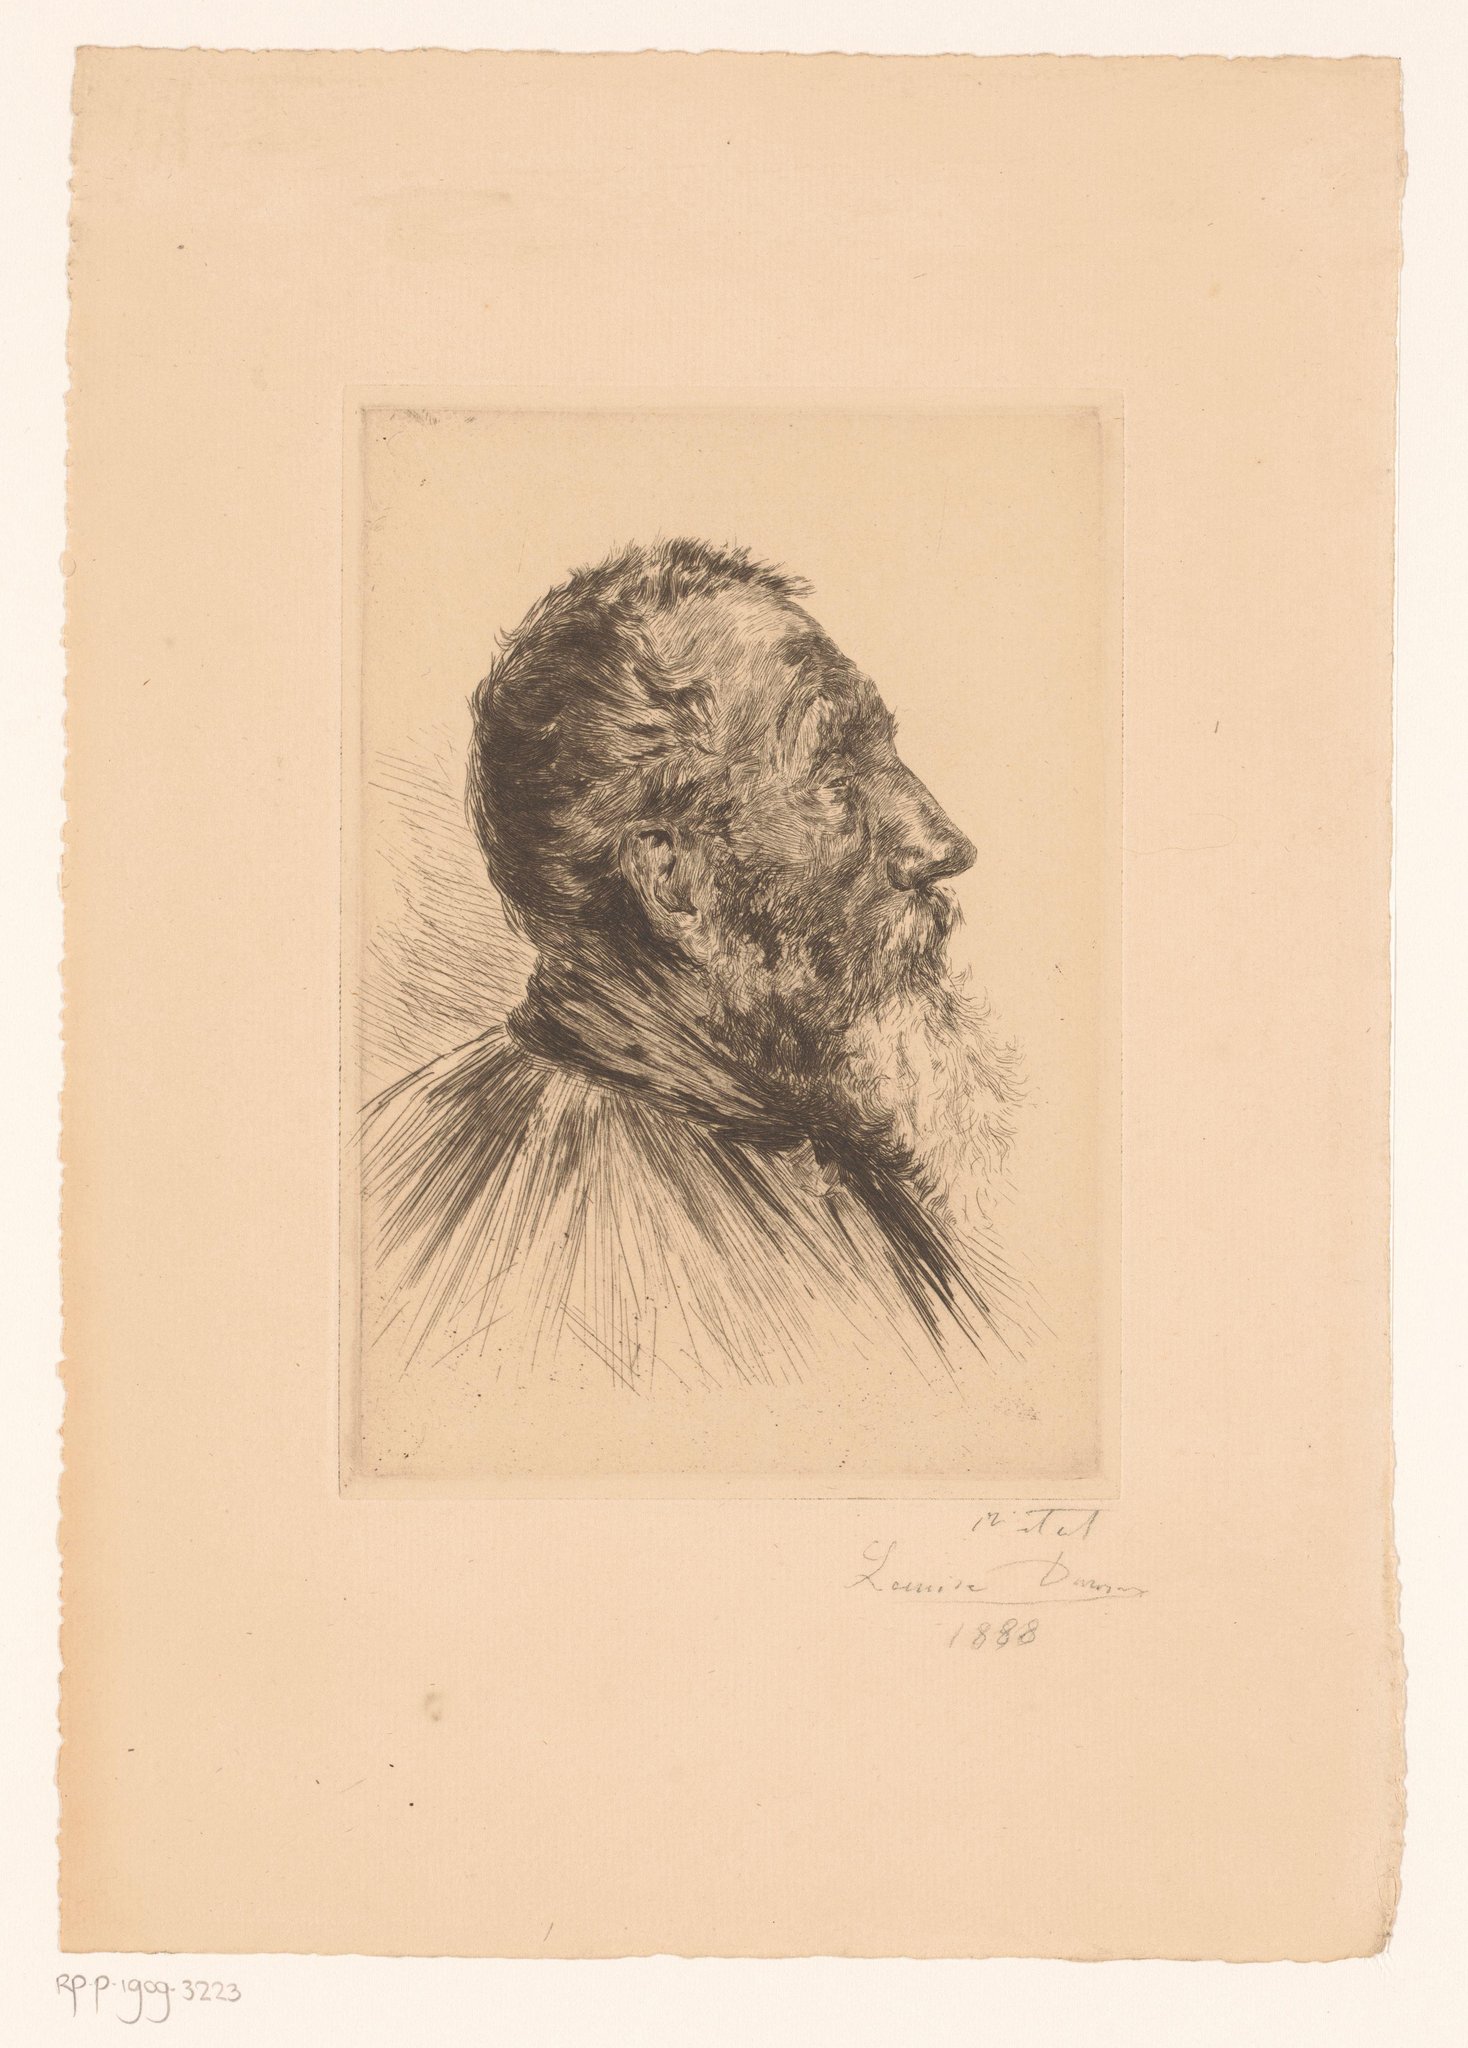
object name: print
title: Portret van een onbekende man, mogelijk een jachtopziener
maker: louise danse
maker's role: painter, print maker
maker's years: 1867-1948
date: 1888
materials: paper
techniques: drypoint, etching, intaglio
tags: anonymous historical person portrayed alone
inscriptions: annotation: ‘garde chasse’, annotation: ‘1er état’, collector's mark: Lugt 2228